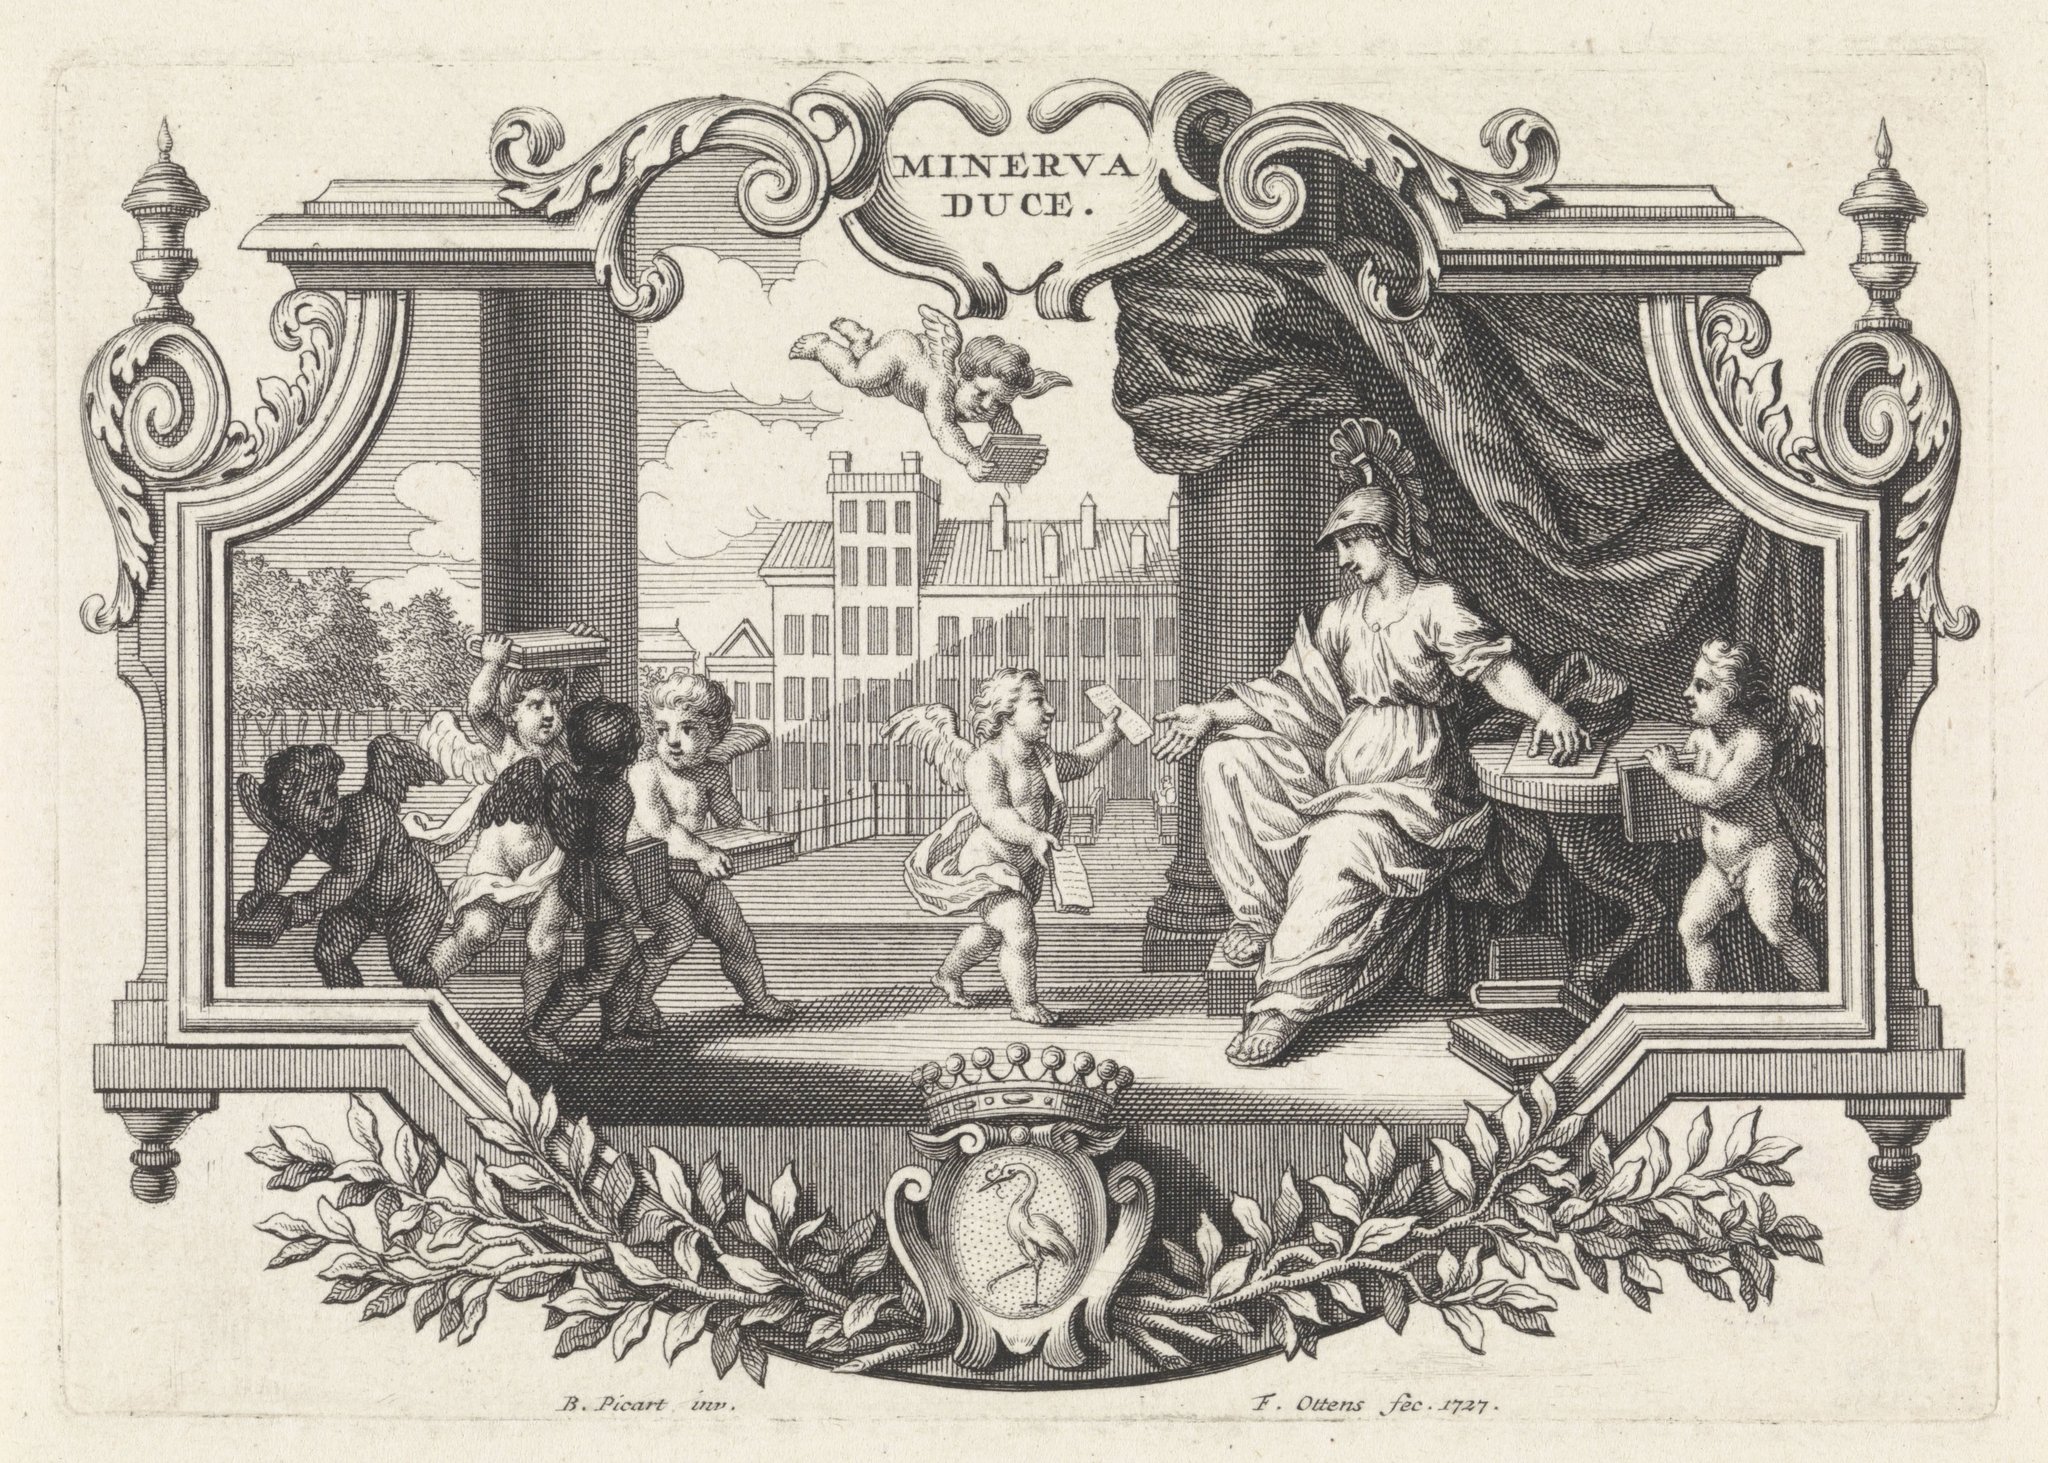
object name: print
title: Allegorische voorstelling `Minerva Duce'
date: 1727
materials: paper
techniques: engraving, etching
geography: amsterdam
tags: (story of) minerva (pallas, athena), the hague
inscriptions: collector's mark: Lugt 240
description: Minerva zit aan tafel en ontvangt putti met boeken en brieven. In een versierde cartouche met onder het wapen van Den Haag.